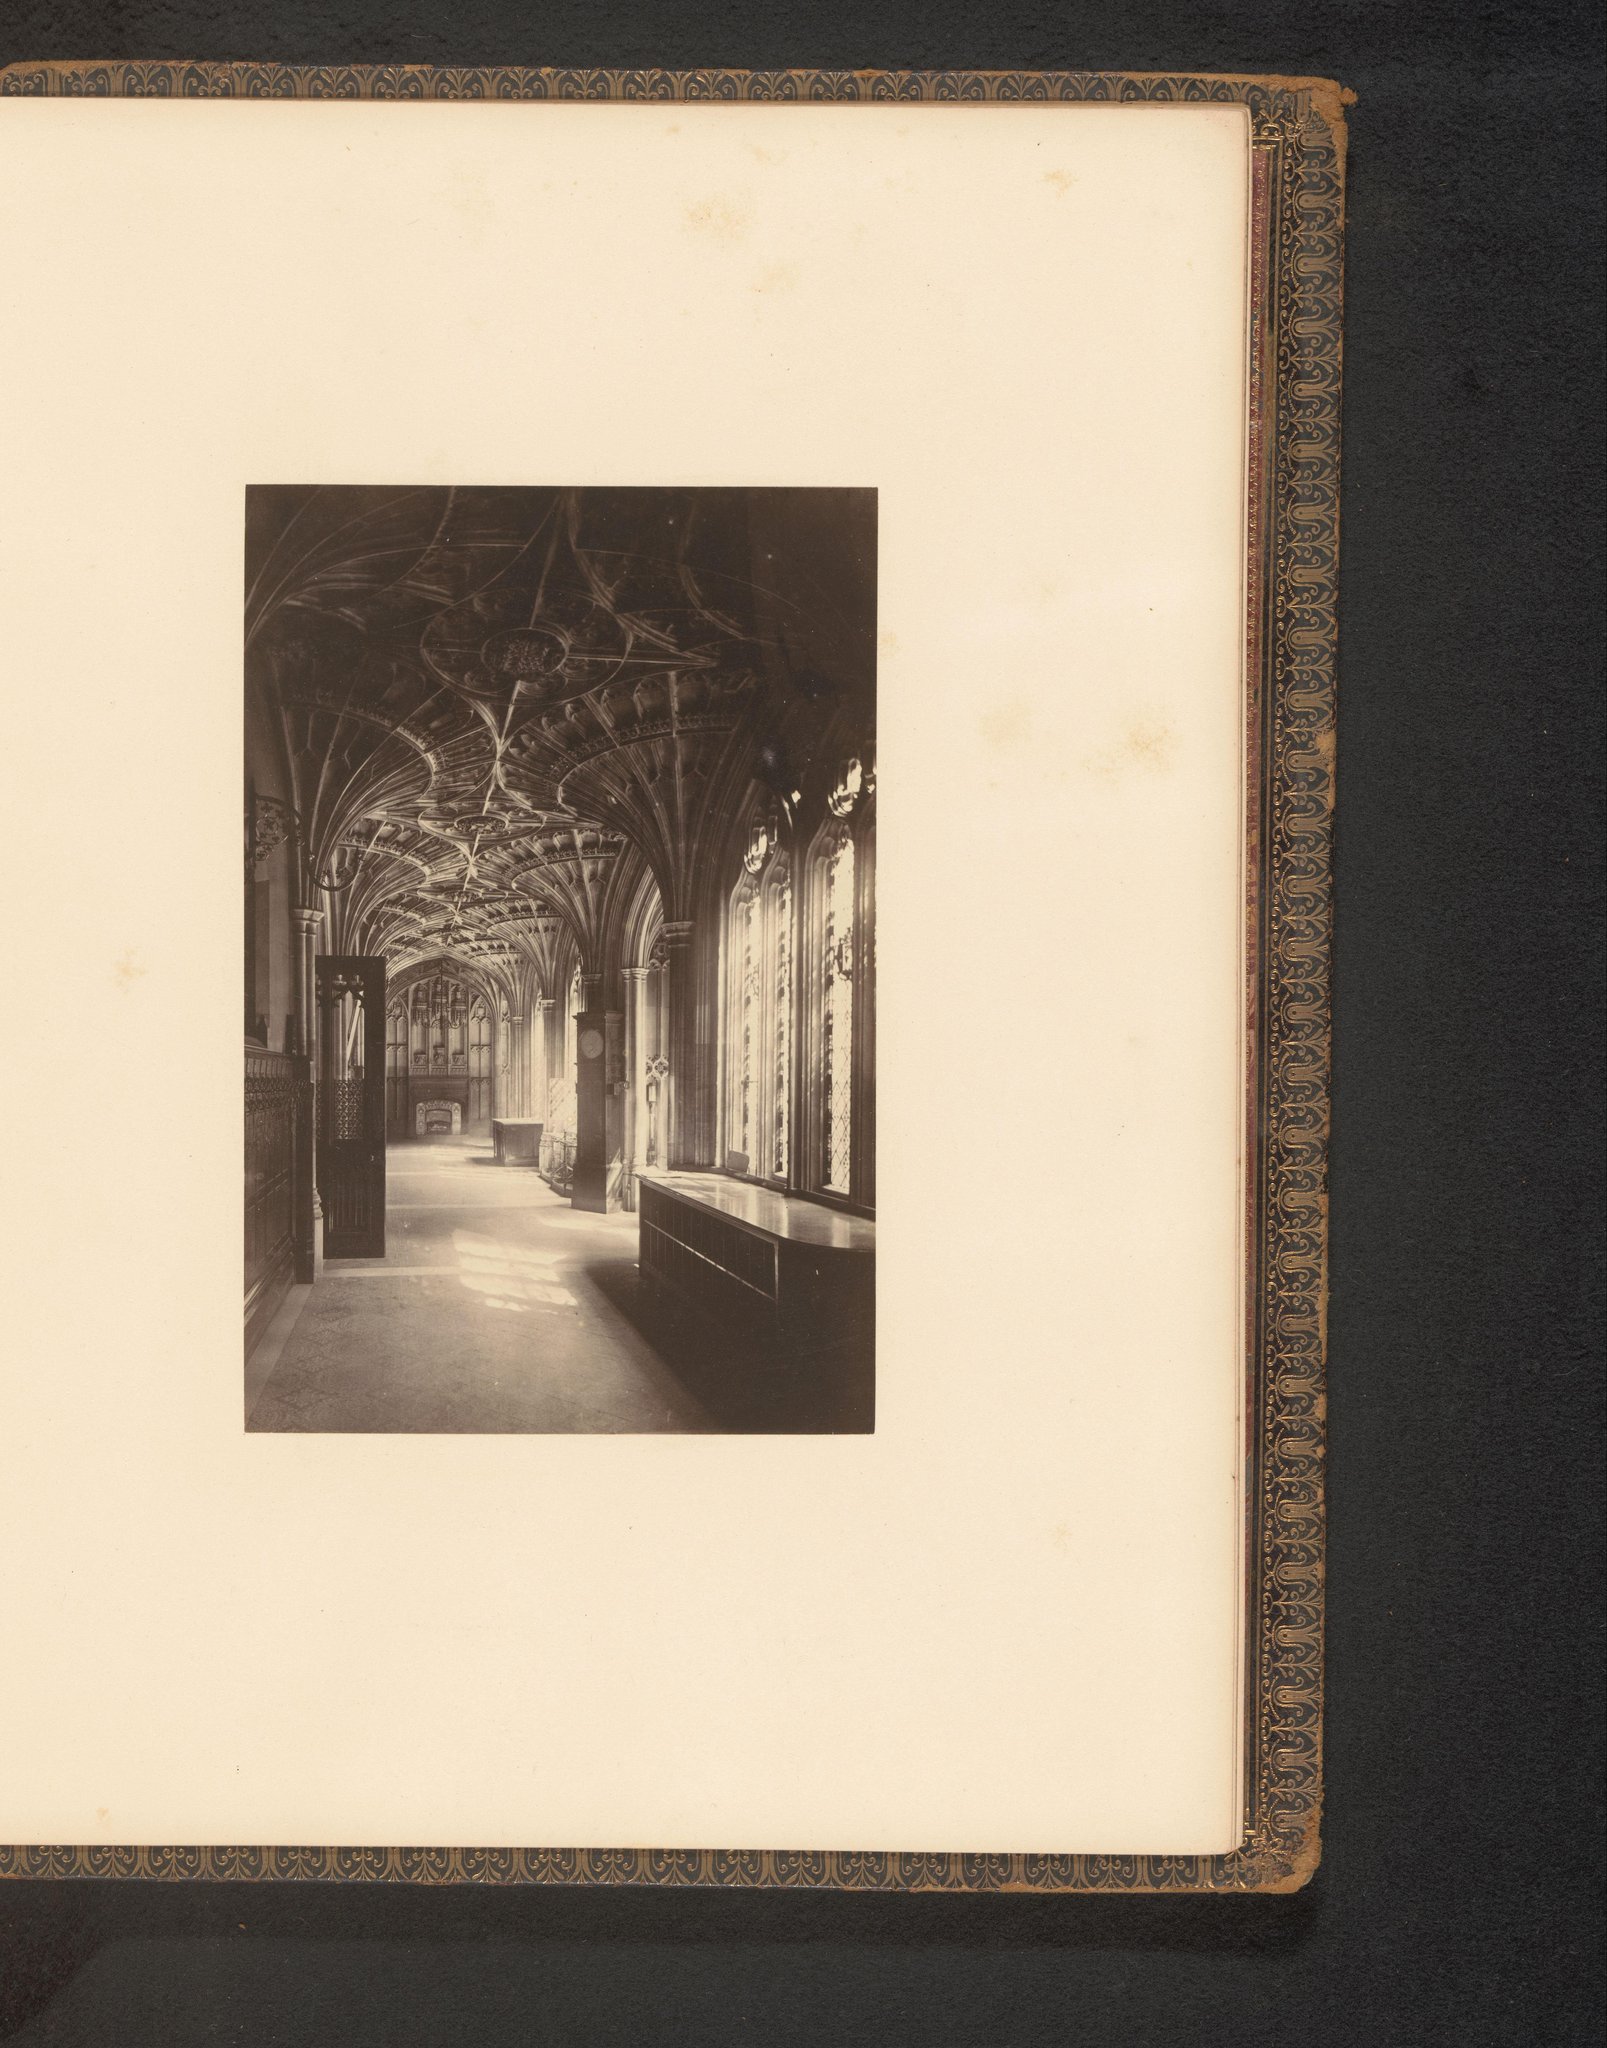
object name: page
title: Hal in Palace of Westminster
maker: john harrington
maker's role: fotograaf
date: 1864-1869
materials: photographic support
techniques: albumen print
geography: london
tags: corridor